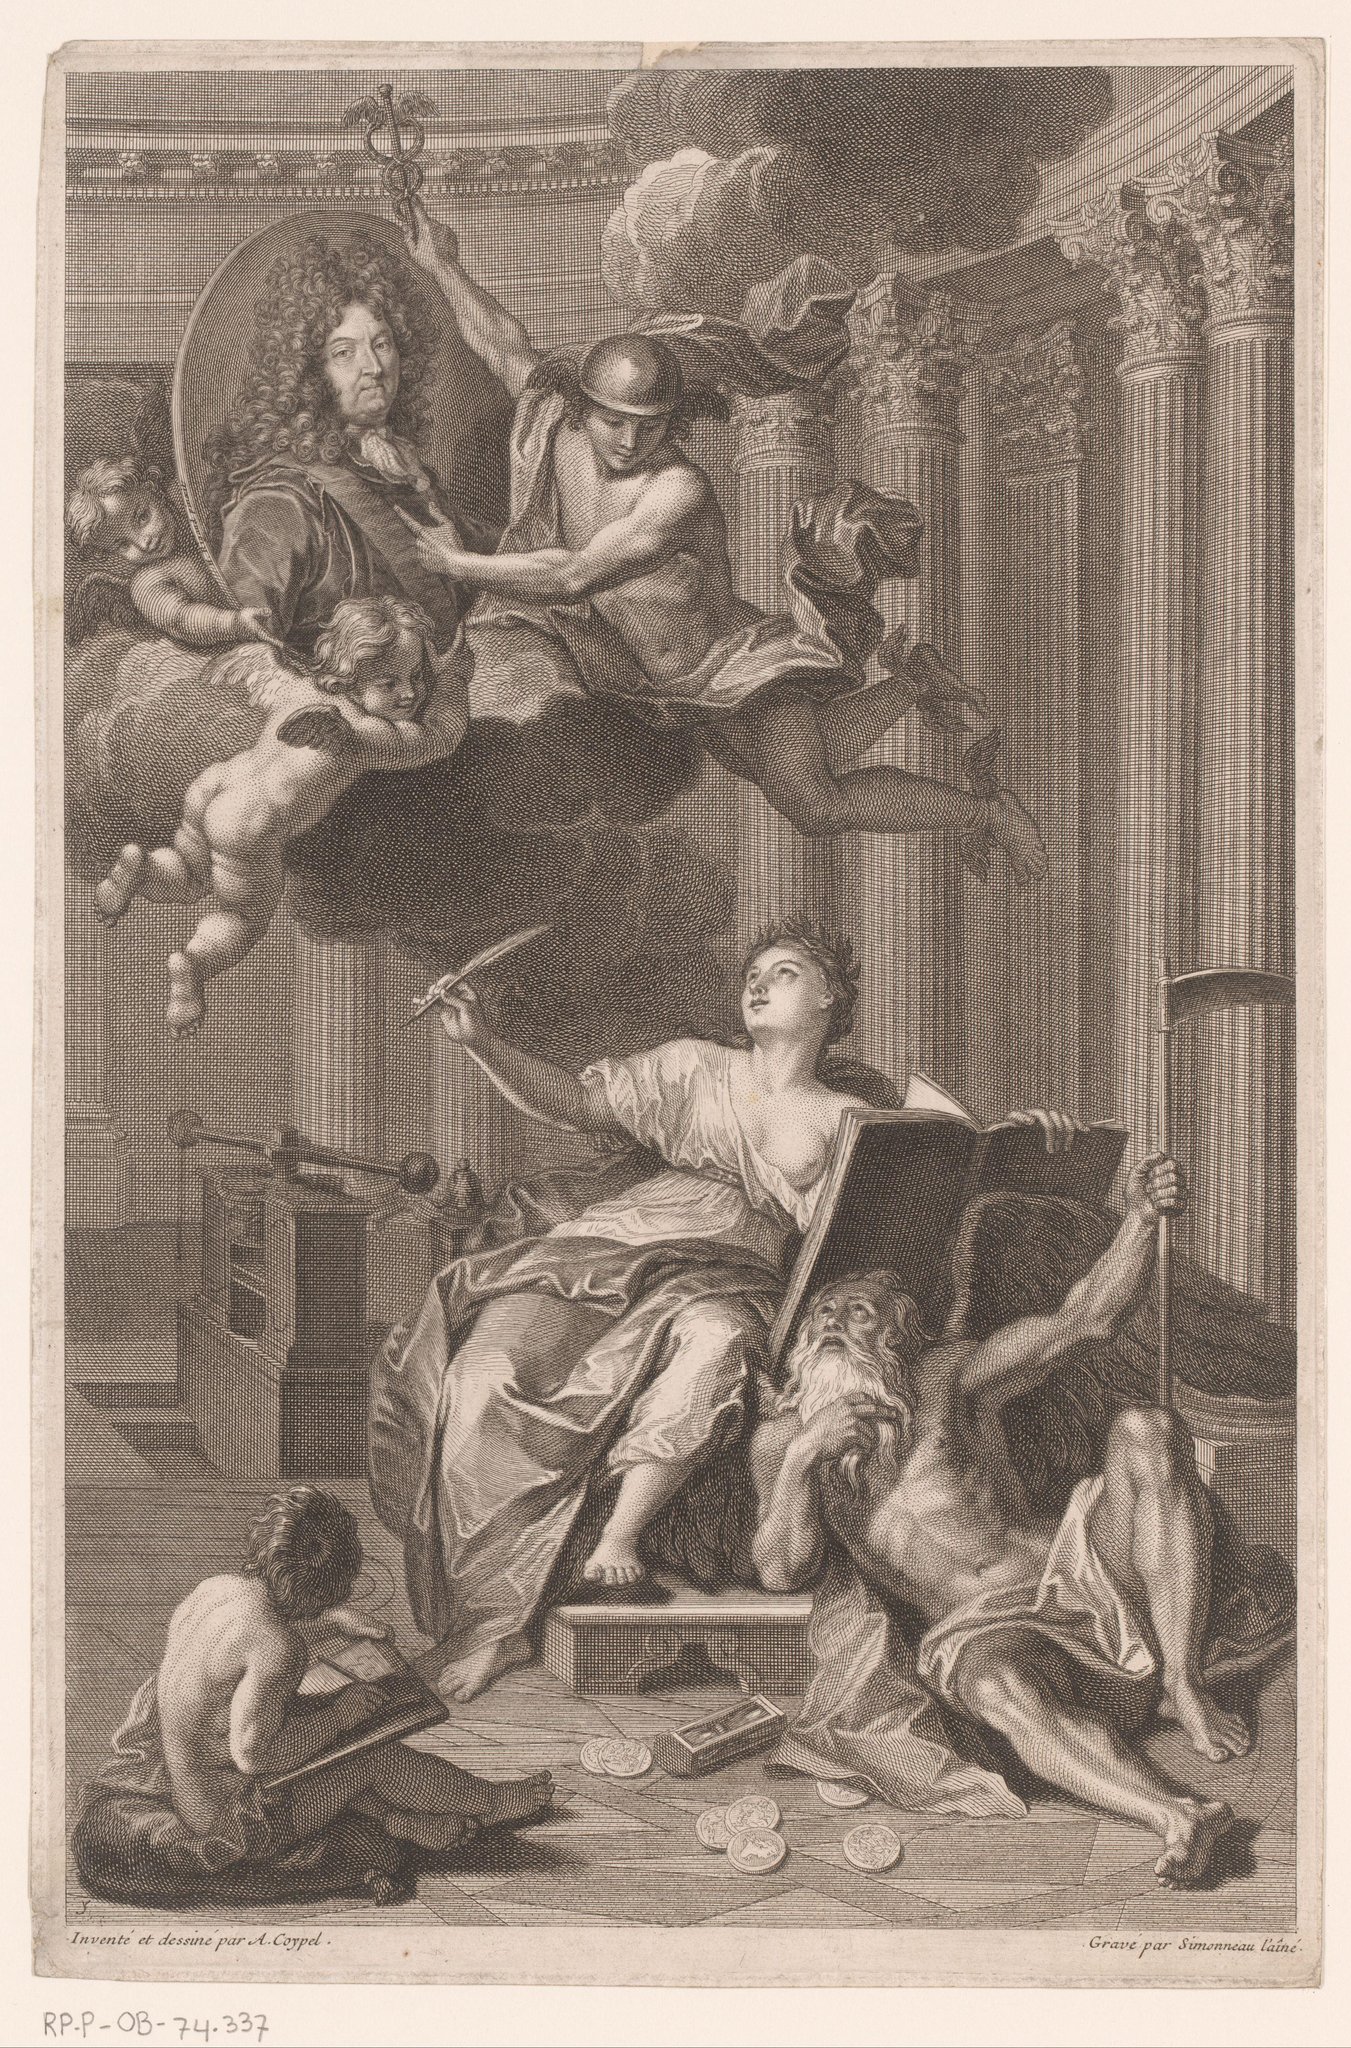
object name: print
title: Allegorie op Lodewijk XIV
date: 1655-1728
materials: paper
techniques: engraving, etching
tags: lodewijk xiv (koning van frankrijk), (story of) mercury (hermes), printing press, specific aspects, allegorical aspects of mercury; mercury as patron, cupids: 'amores', 'amoretti', 'putti', father time, man with wings and scythe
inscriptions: collector's mark: Lugt 2228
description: Portret van Lodewijk XIV opgehouden door Mercurius boven een schrijvende vrouw en de Tijd.